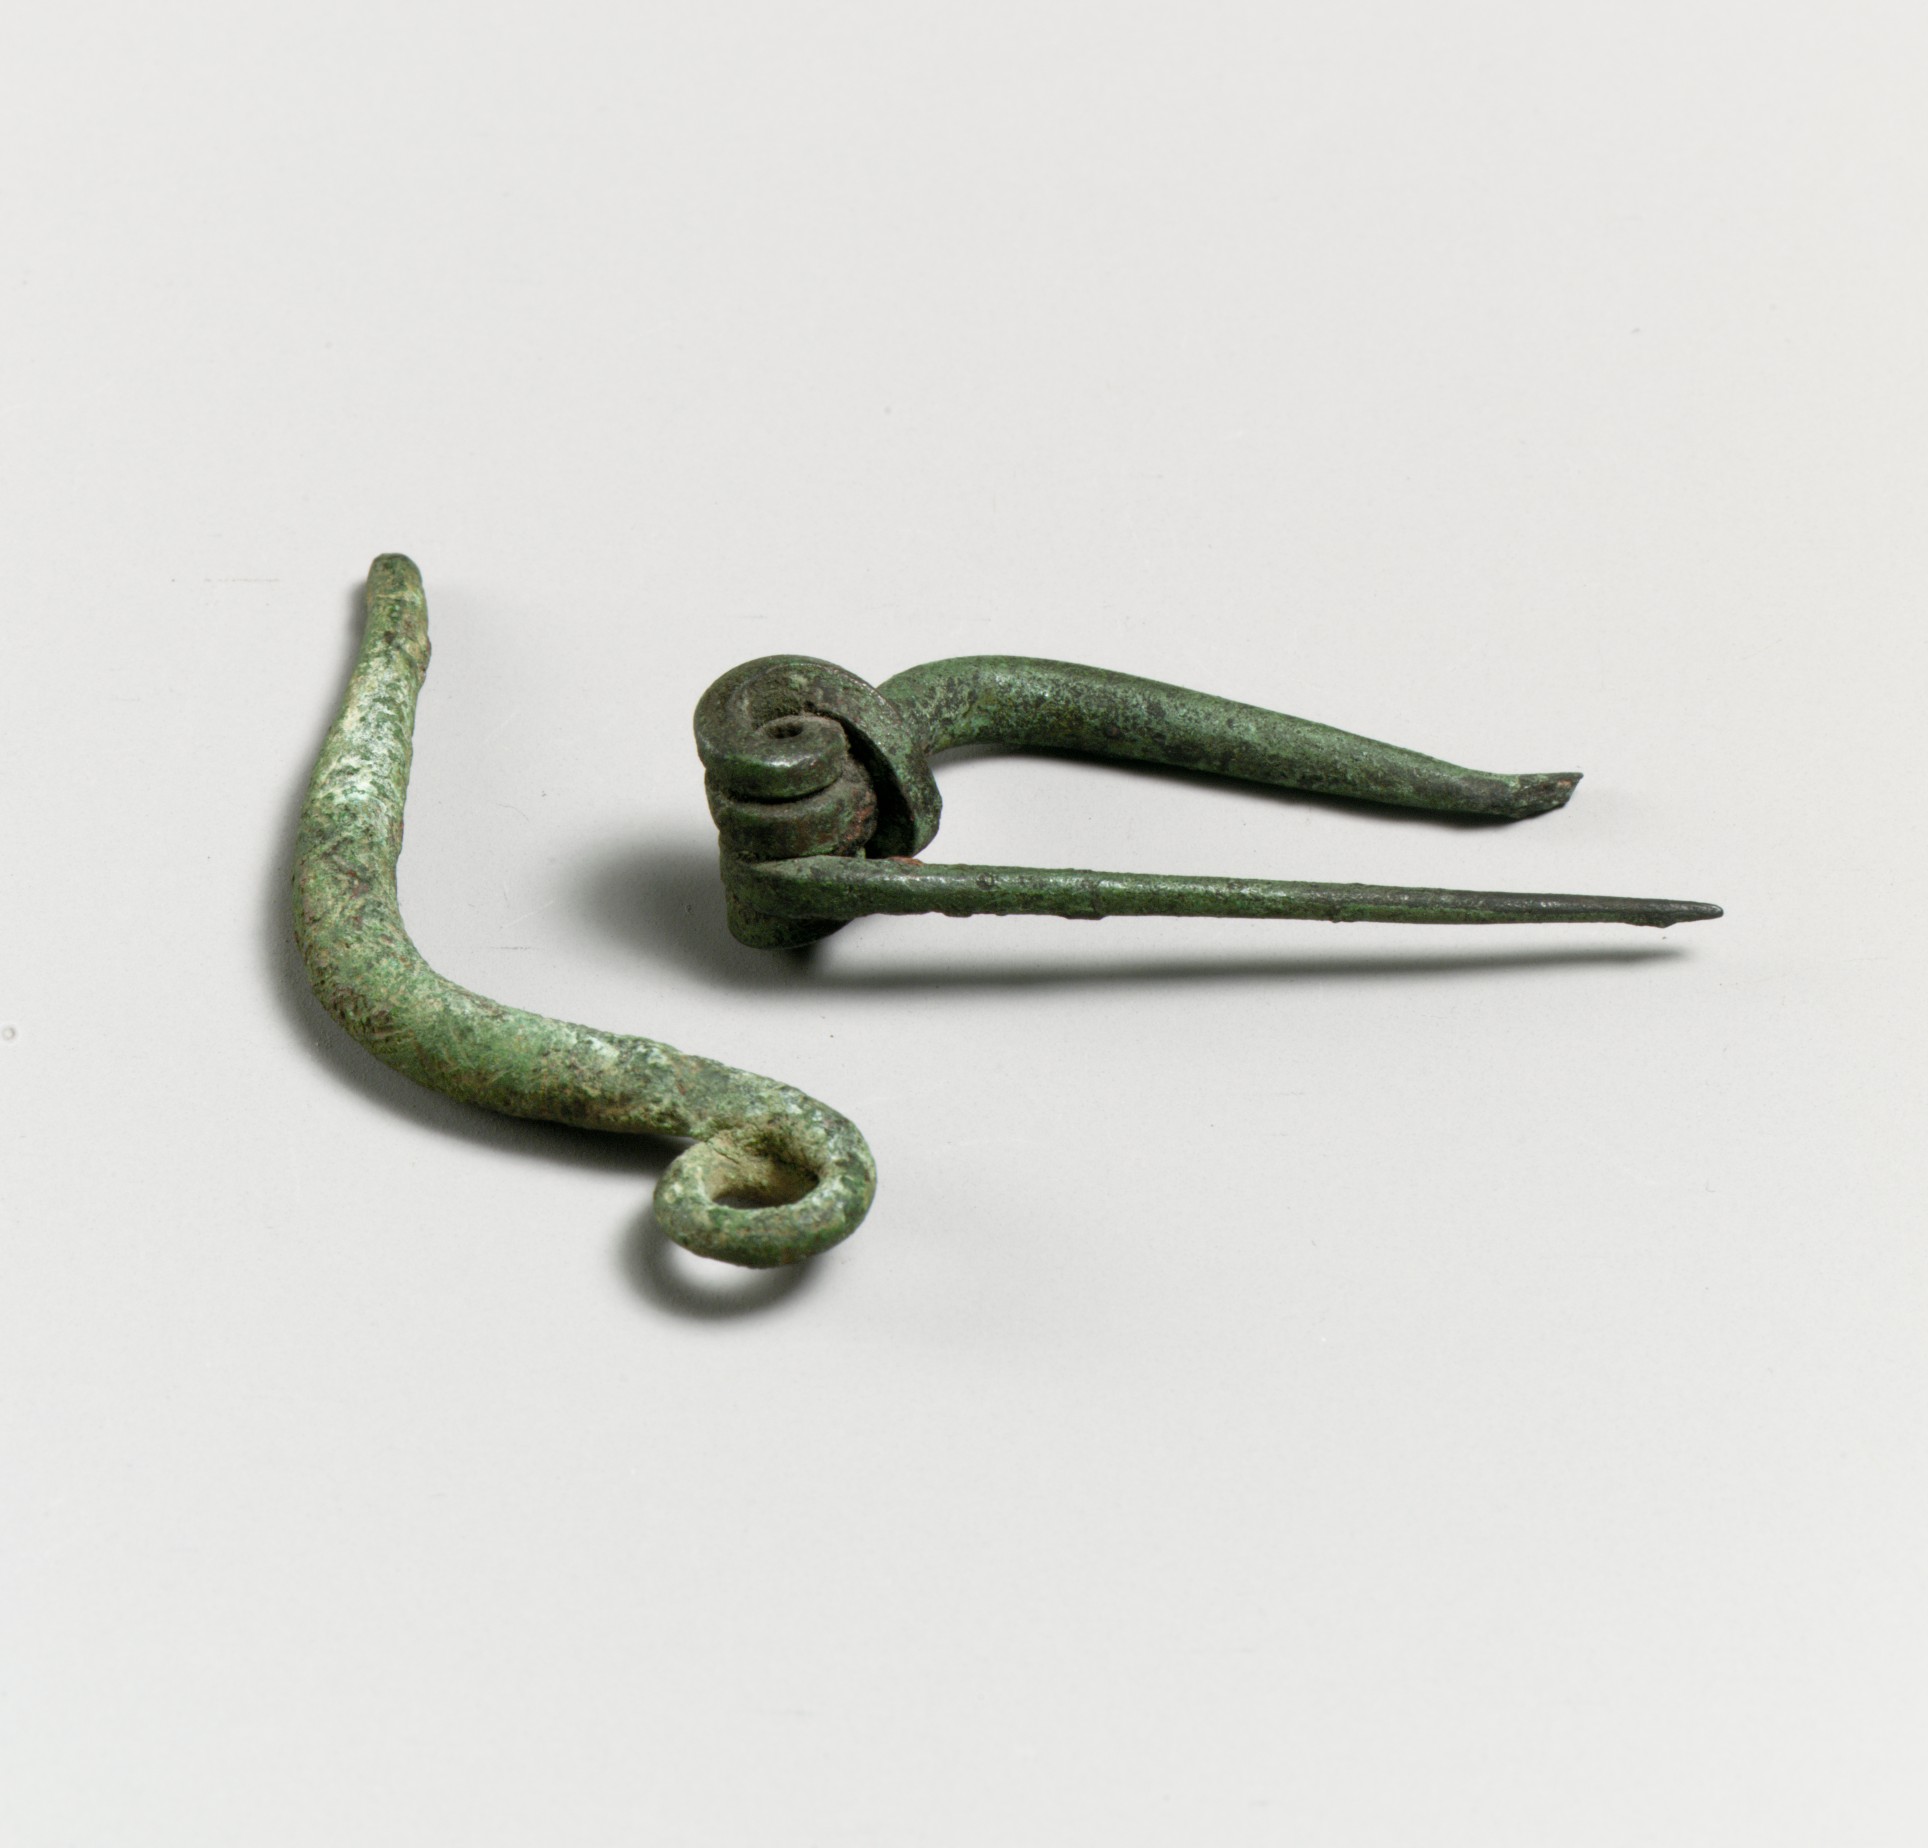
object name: fibula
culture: cypriot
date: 3900 BCE-100 CE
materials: bronze